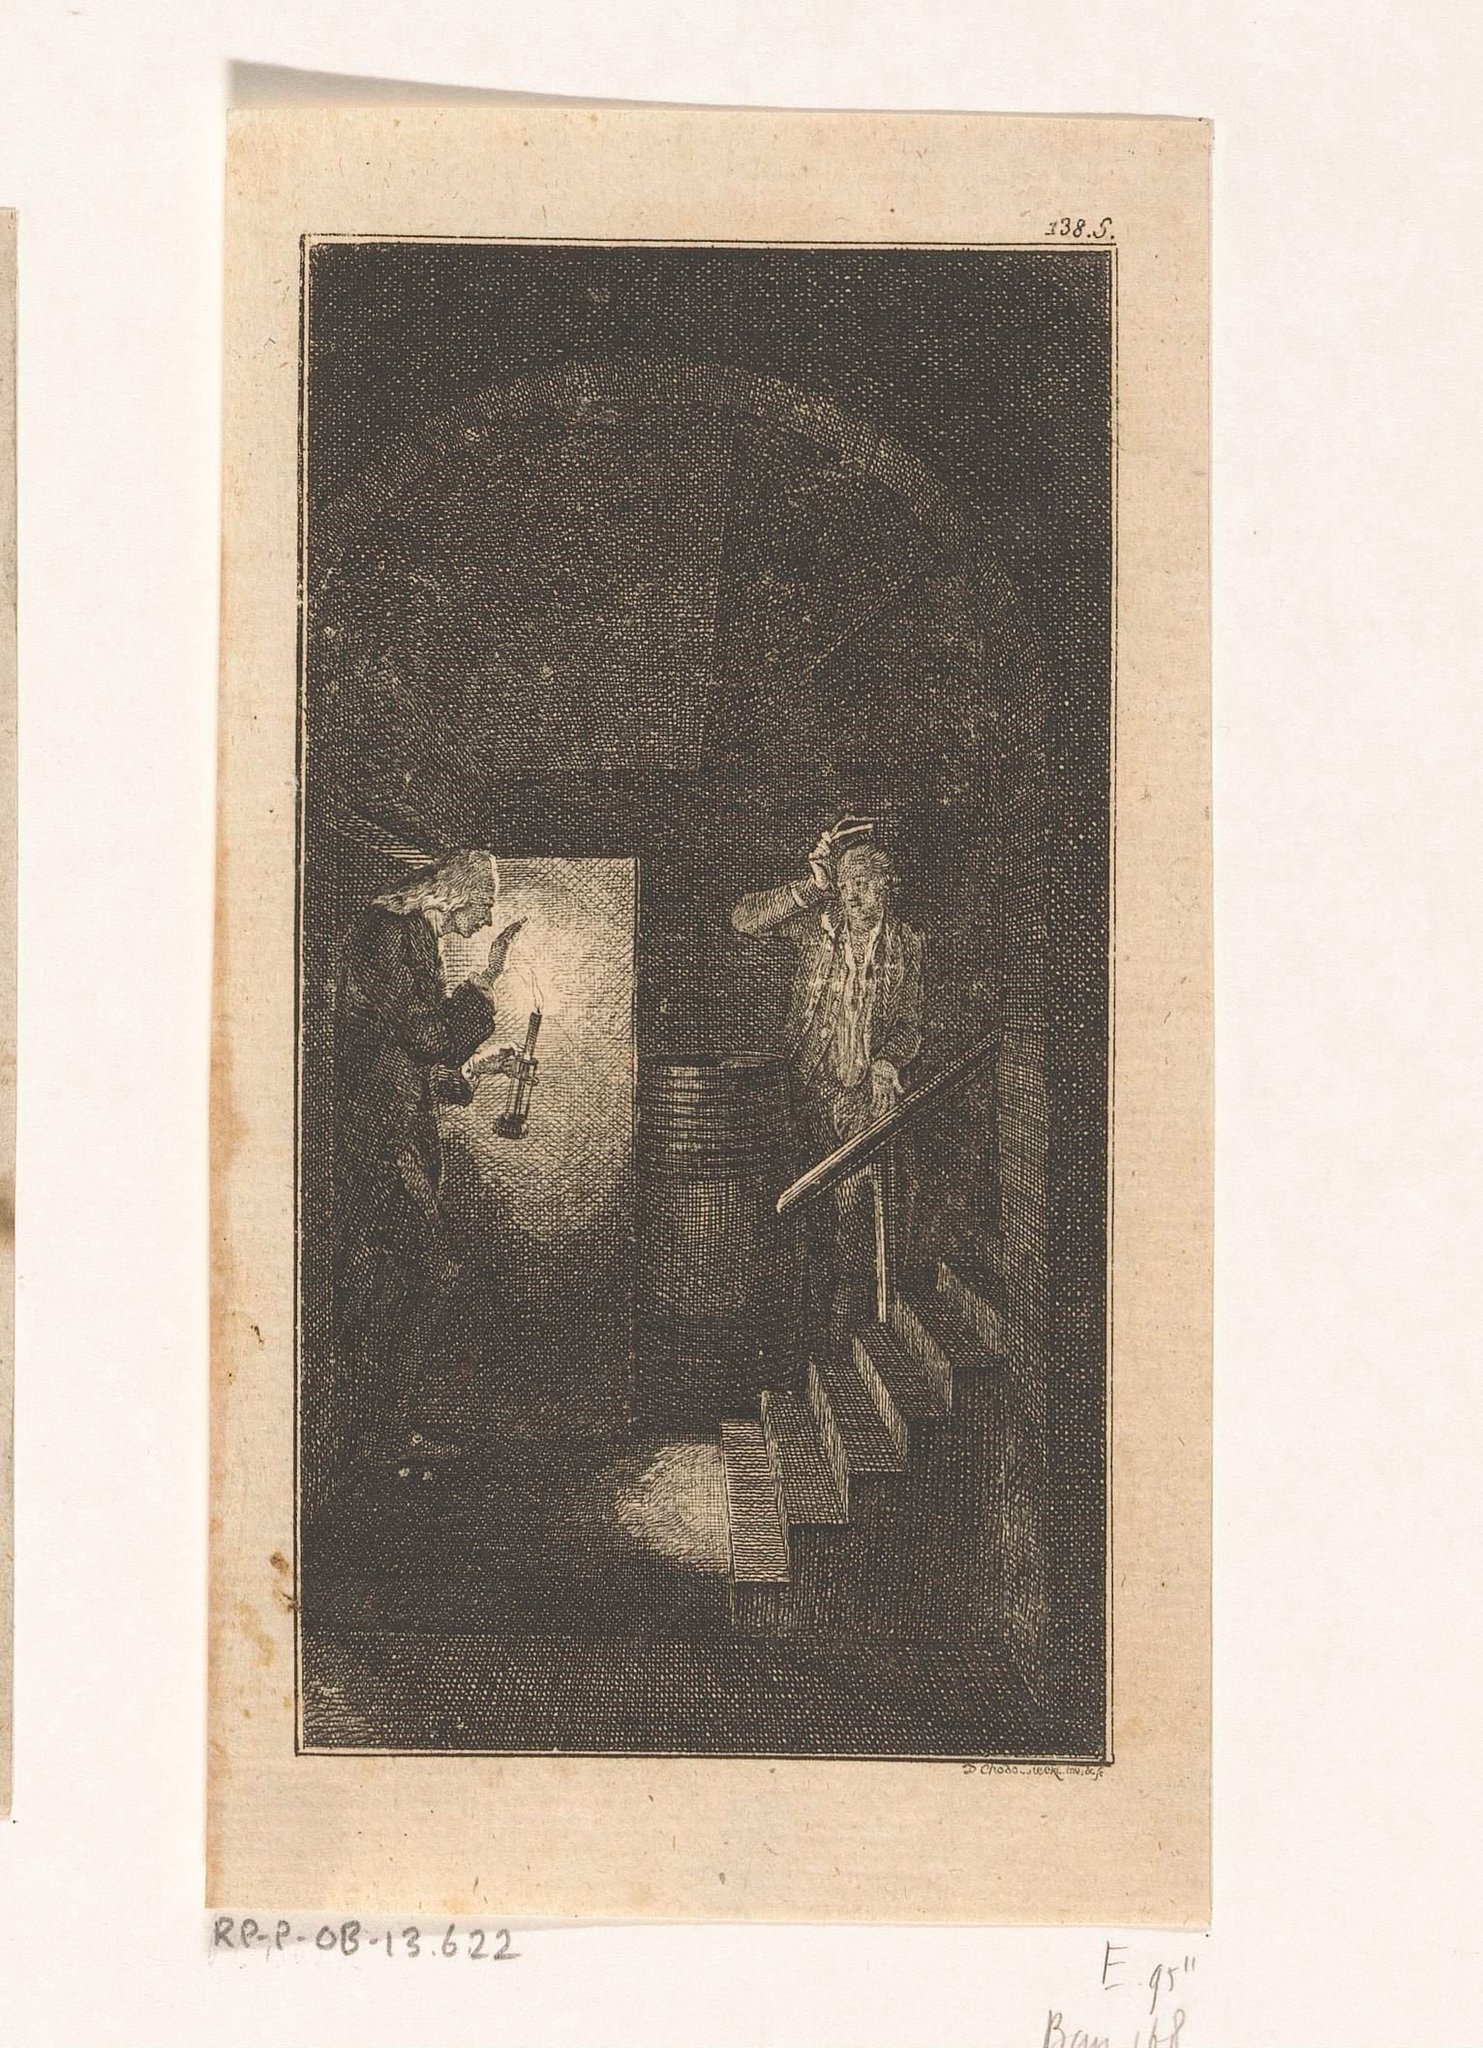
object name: print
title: Sebaldus Nothanker in de kelder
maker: daniel nikolaus chodowiecki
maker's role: draughtsman, print maker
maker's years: 1726-1801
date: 1773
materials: paper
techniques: etching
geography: berlin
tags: berlin, friedrich nicolai, literature, hiding, hiding oneself, cellar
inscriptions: collector's mark: Lugt 2228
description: Deze scène behoort tot een serie prenten die het verhaal van Sebaldus Nothanker door Friedrich Nicolai illustreren. De tweede staat van deze serie werd gebruikt in: [Nicolai Friedrich]. Das Leben und die Meinungen des Herrn Magister Sebaldus Nothanker. Berlijn en Stettin: Friedrich Nicolai, 1773 [eerste editie], dl. 1.